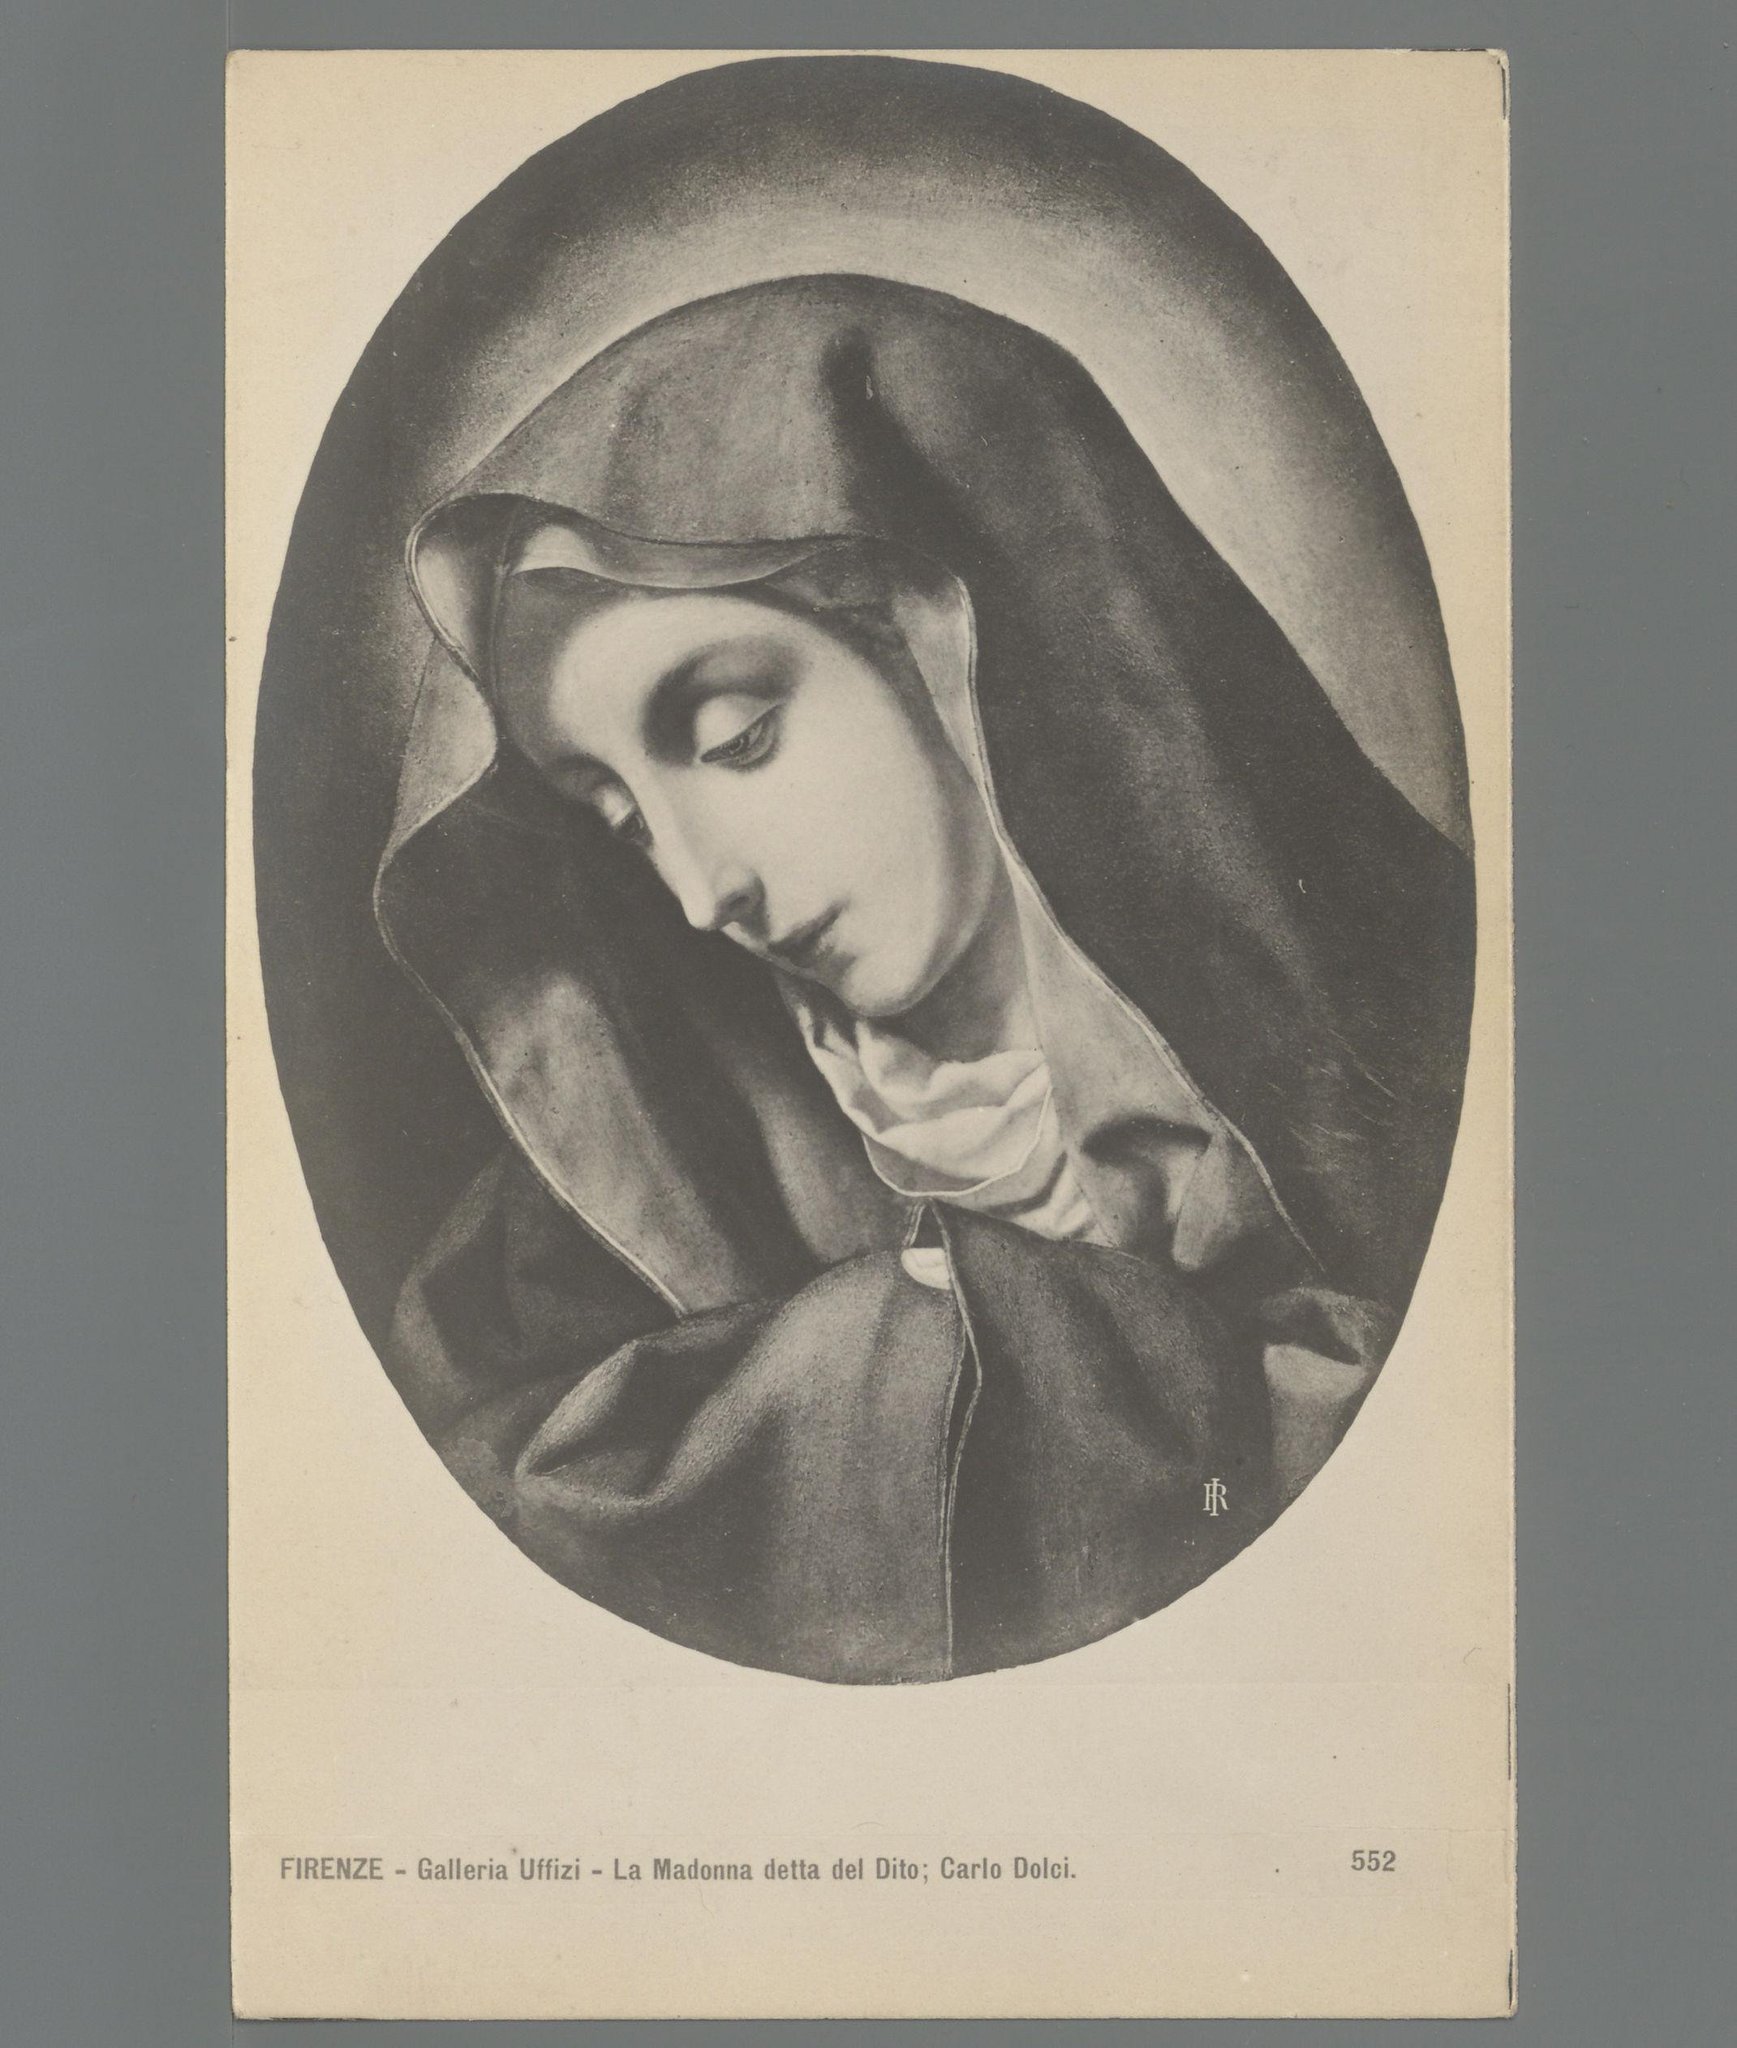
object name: reproduction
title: Firenze. Galleria Uffizi. La Madonna detta del Dito: Carlo Dolci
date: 1906-1930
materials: photographic support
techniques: photography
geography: florence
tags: 'portraits' of mary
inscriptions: collector's mark: ‘AFE v S’